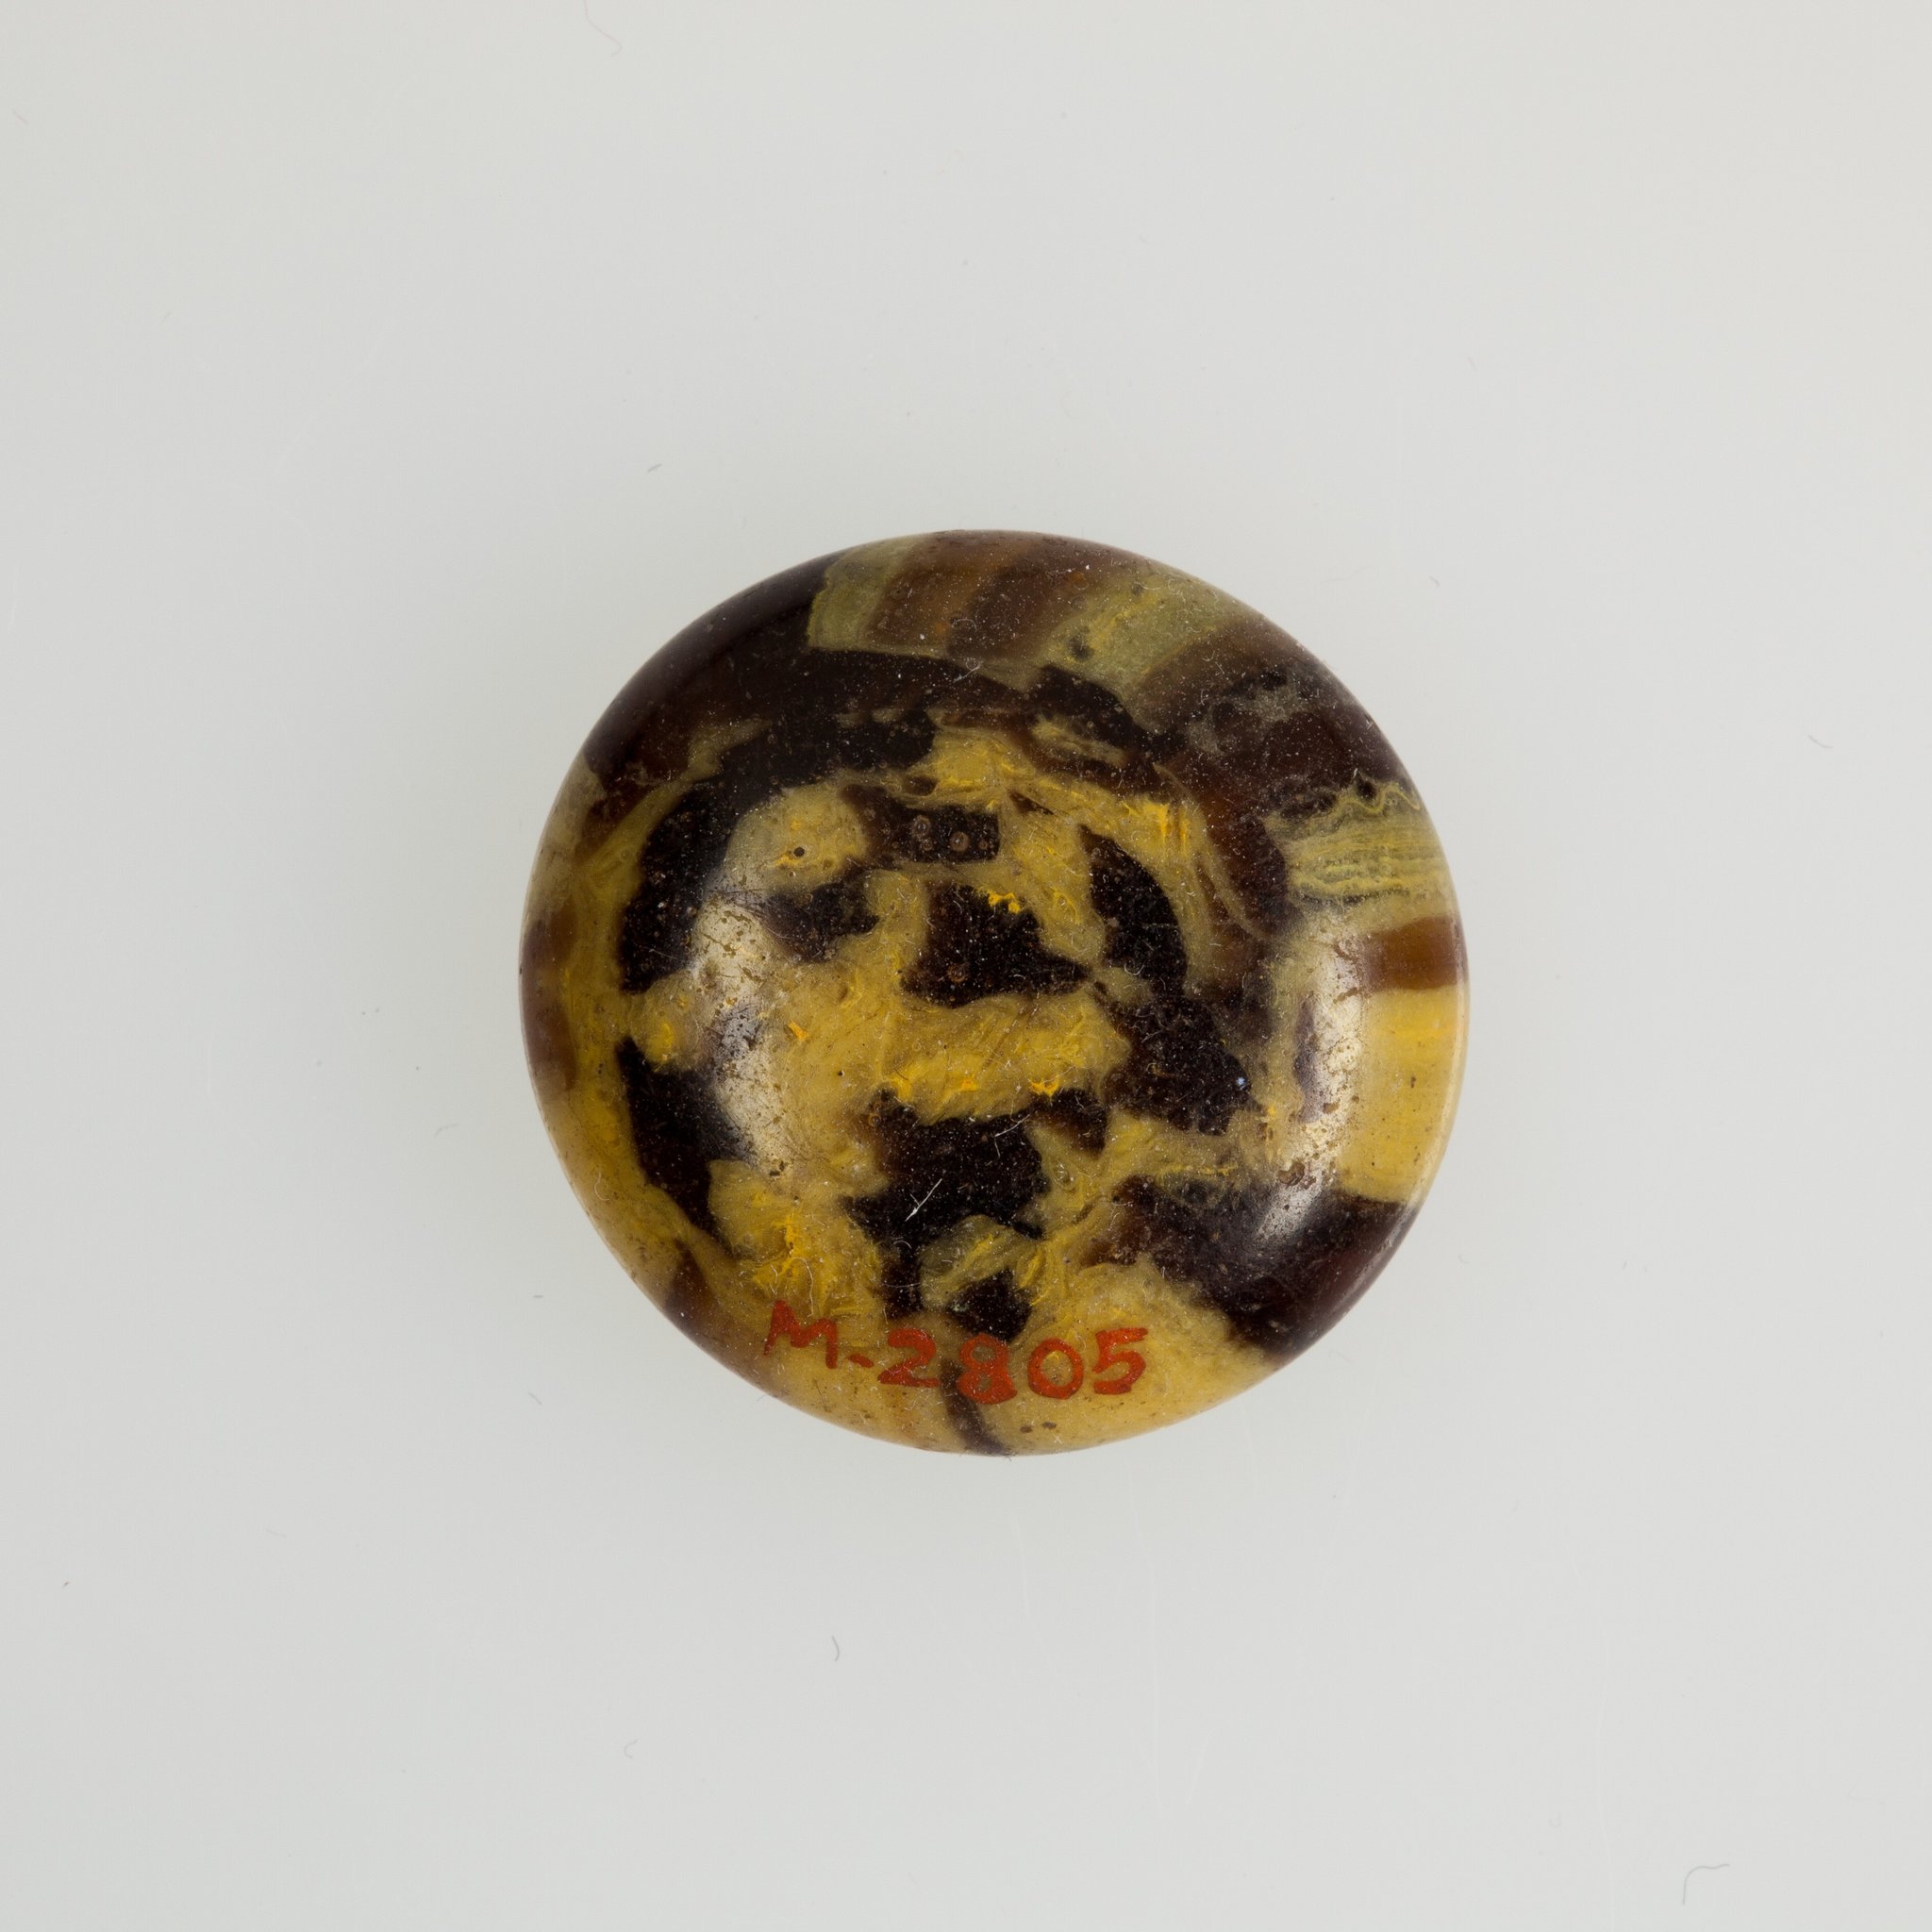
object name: disk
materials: glass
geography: egypt